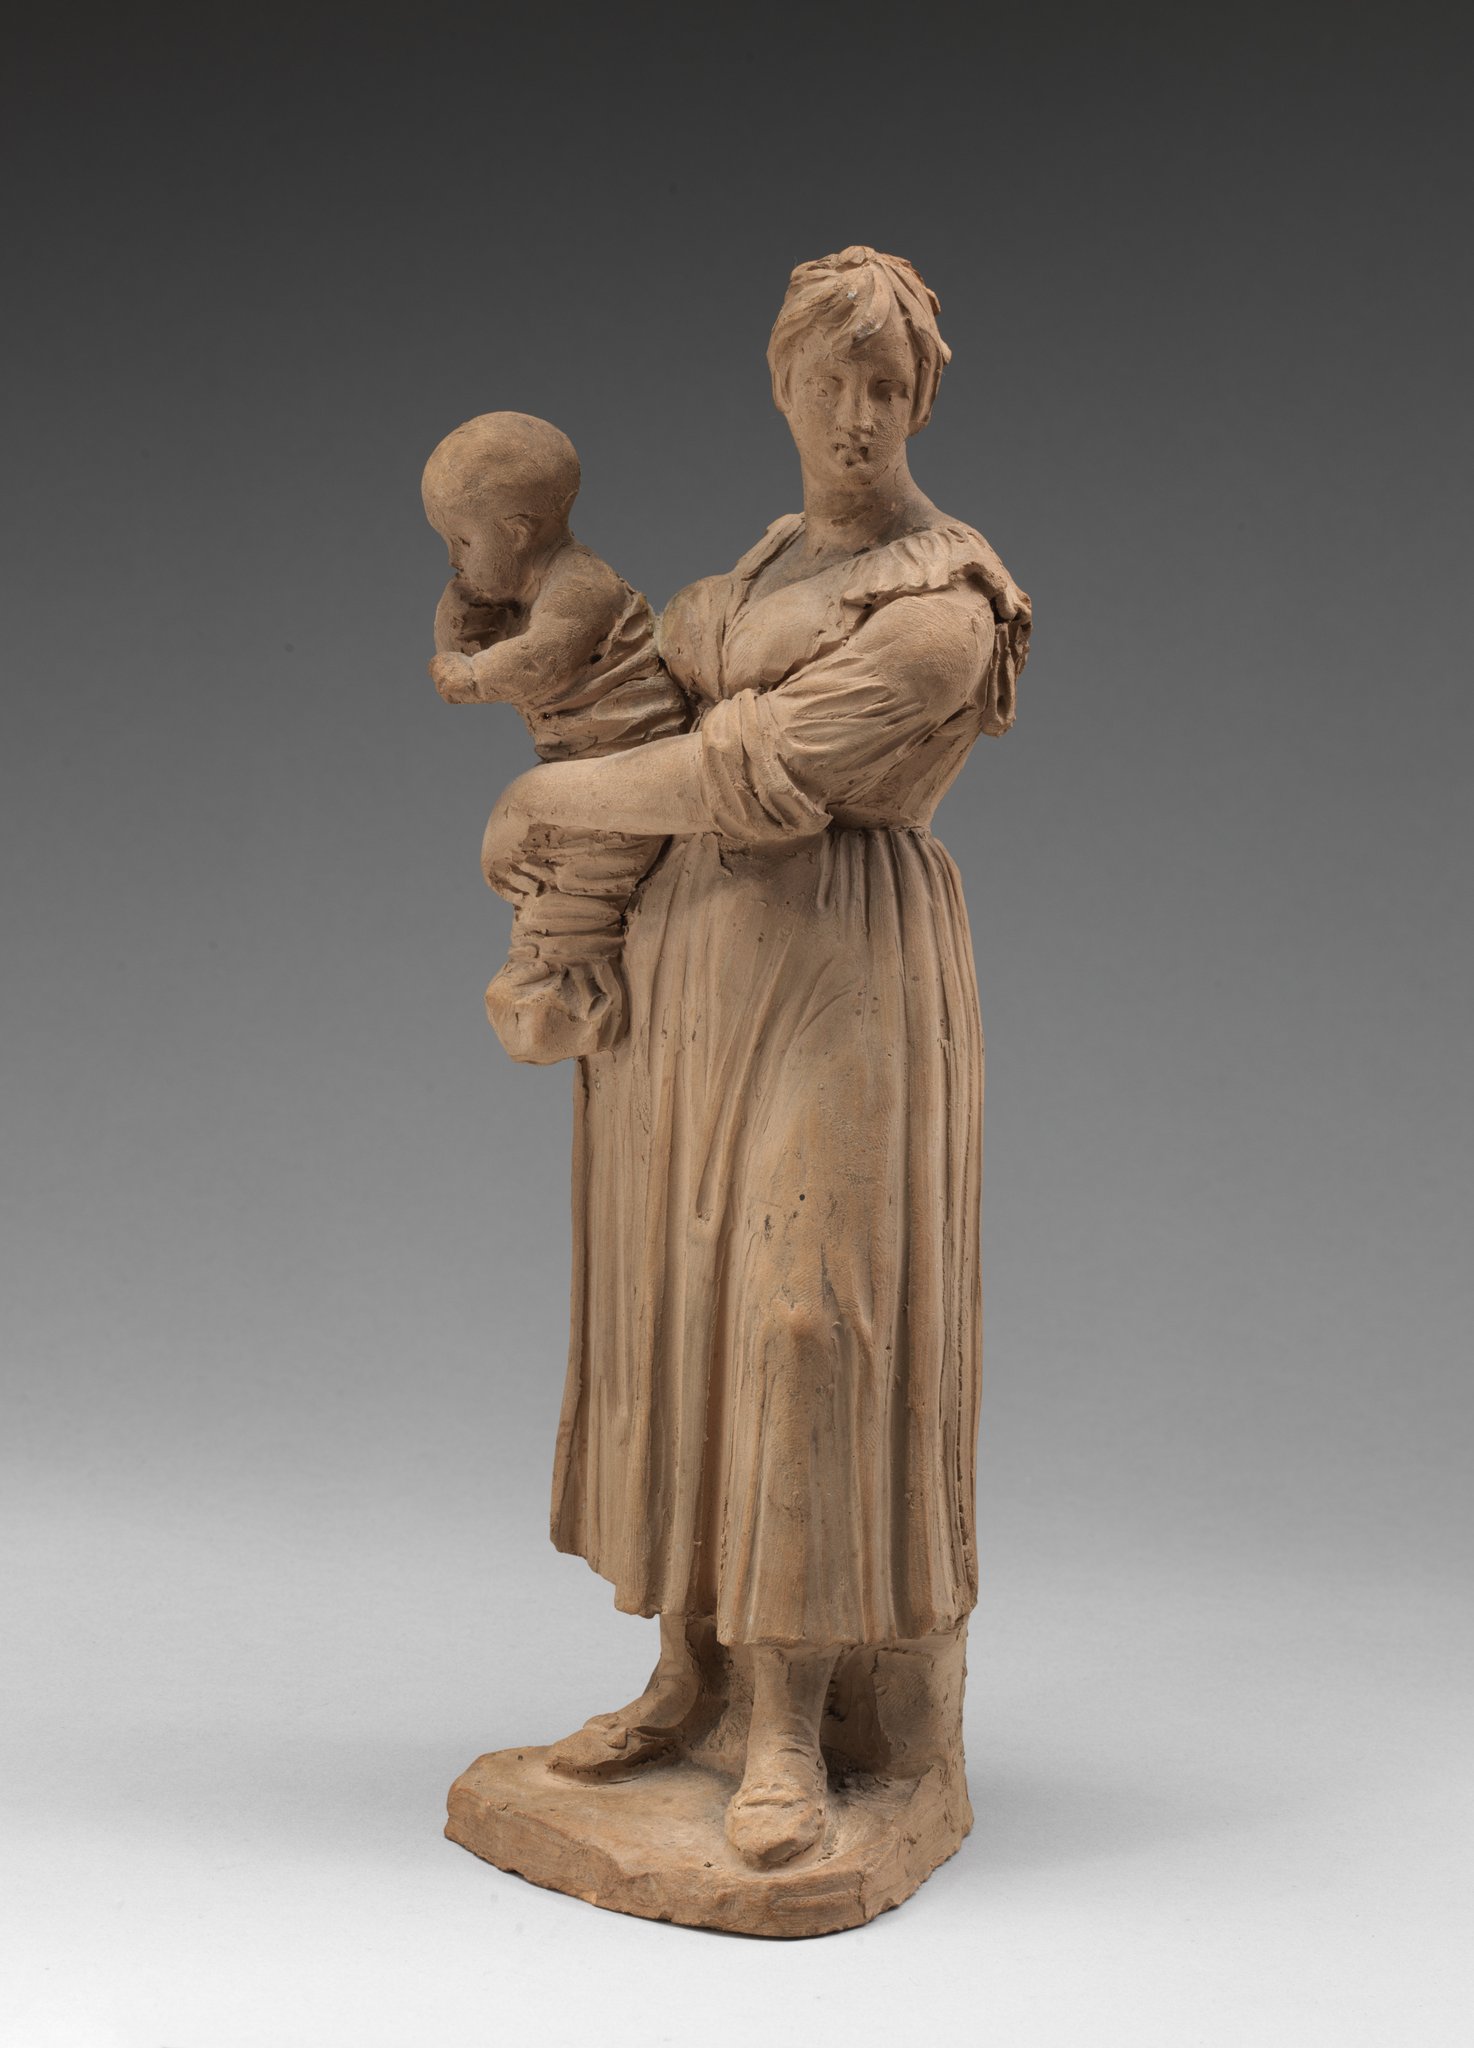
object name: statuette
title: Mother and Child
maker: bartolomeo pinelli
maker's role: artist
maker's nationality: italian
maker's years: 1781-1835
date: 1812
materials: terracotta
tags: infants,mothers,women